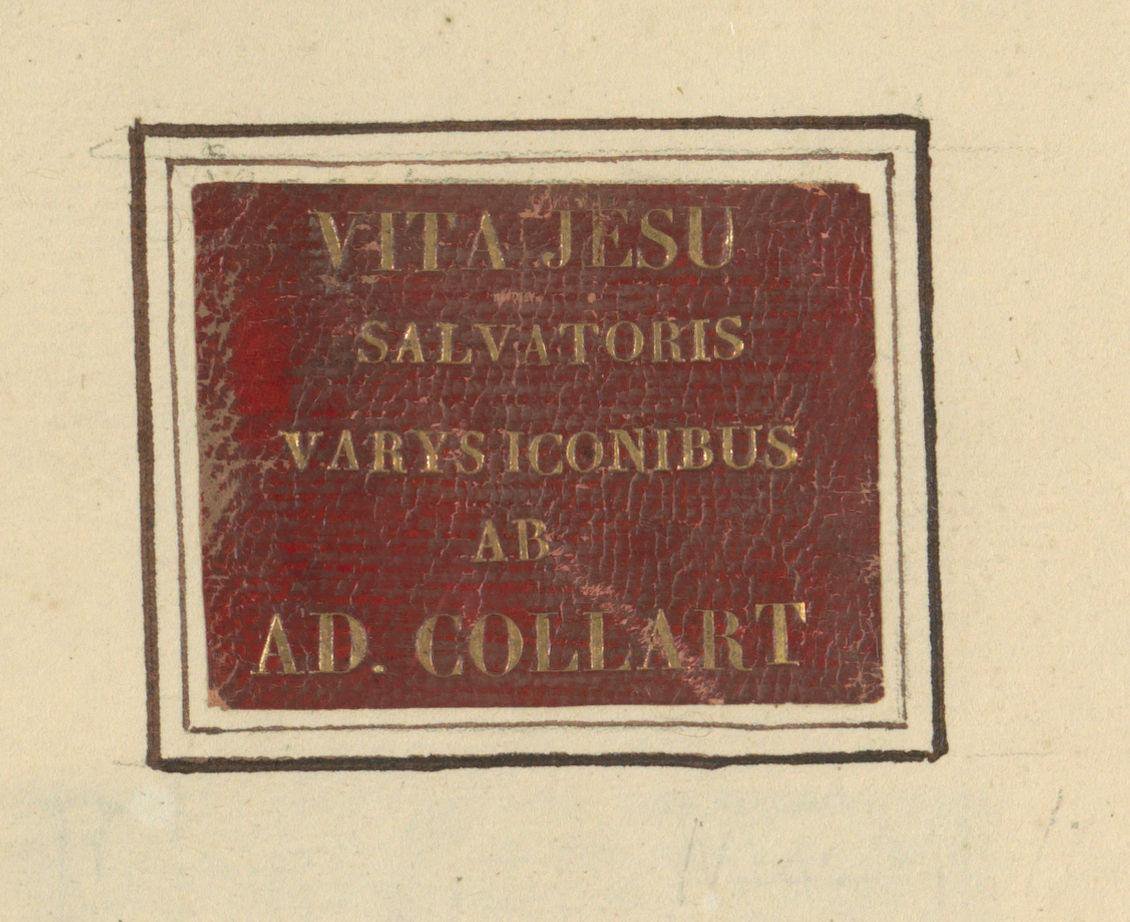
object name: tekst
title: Gedrukte titel: Vita Jesu Salvatoris Varys Iconibus Ab Ad. Collart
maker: Anonymous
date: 1580-1590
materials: gold, leather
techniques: letterpress printing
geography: antwerp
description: Op leer gedrukte titel in gouddruk: Vita Jesu Salvatoris Varys Iconibus Ab Ad. Collart. Onderdeel van de prentserie over het leven van Christus: Vita Iesu Salvatoris varijs iconibus ab Adriano Collaert expressa. In prentalbum met twee reeksen van respectievelijk 34 en 25 gravures met scènes uit het leven en het lijdensverhaal van Christus.